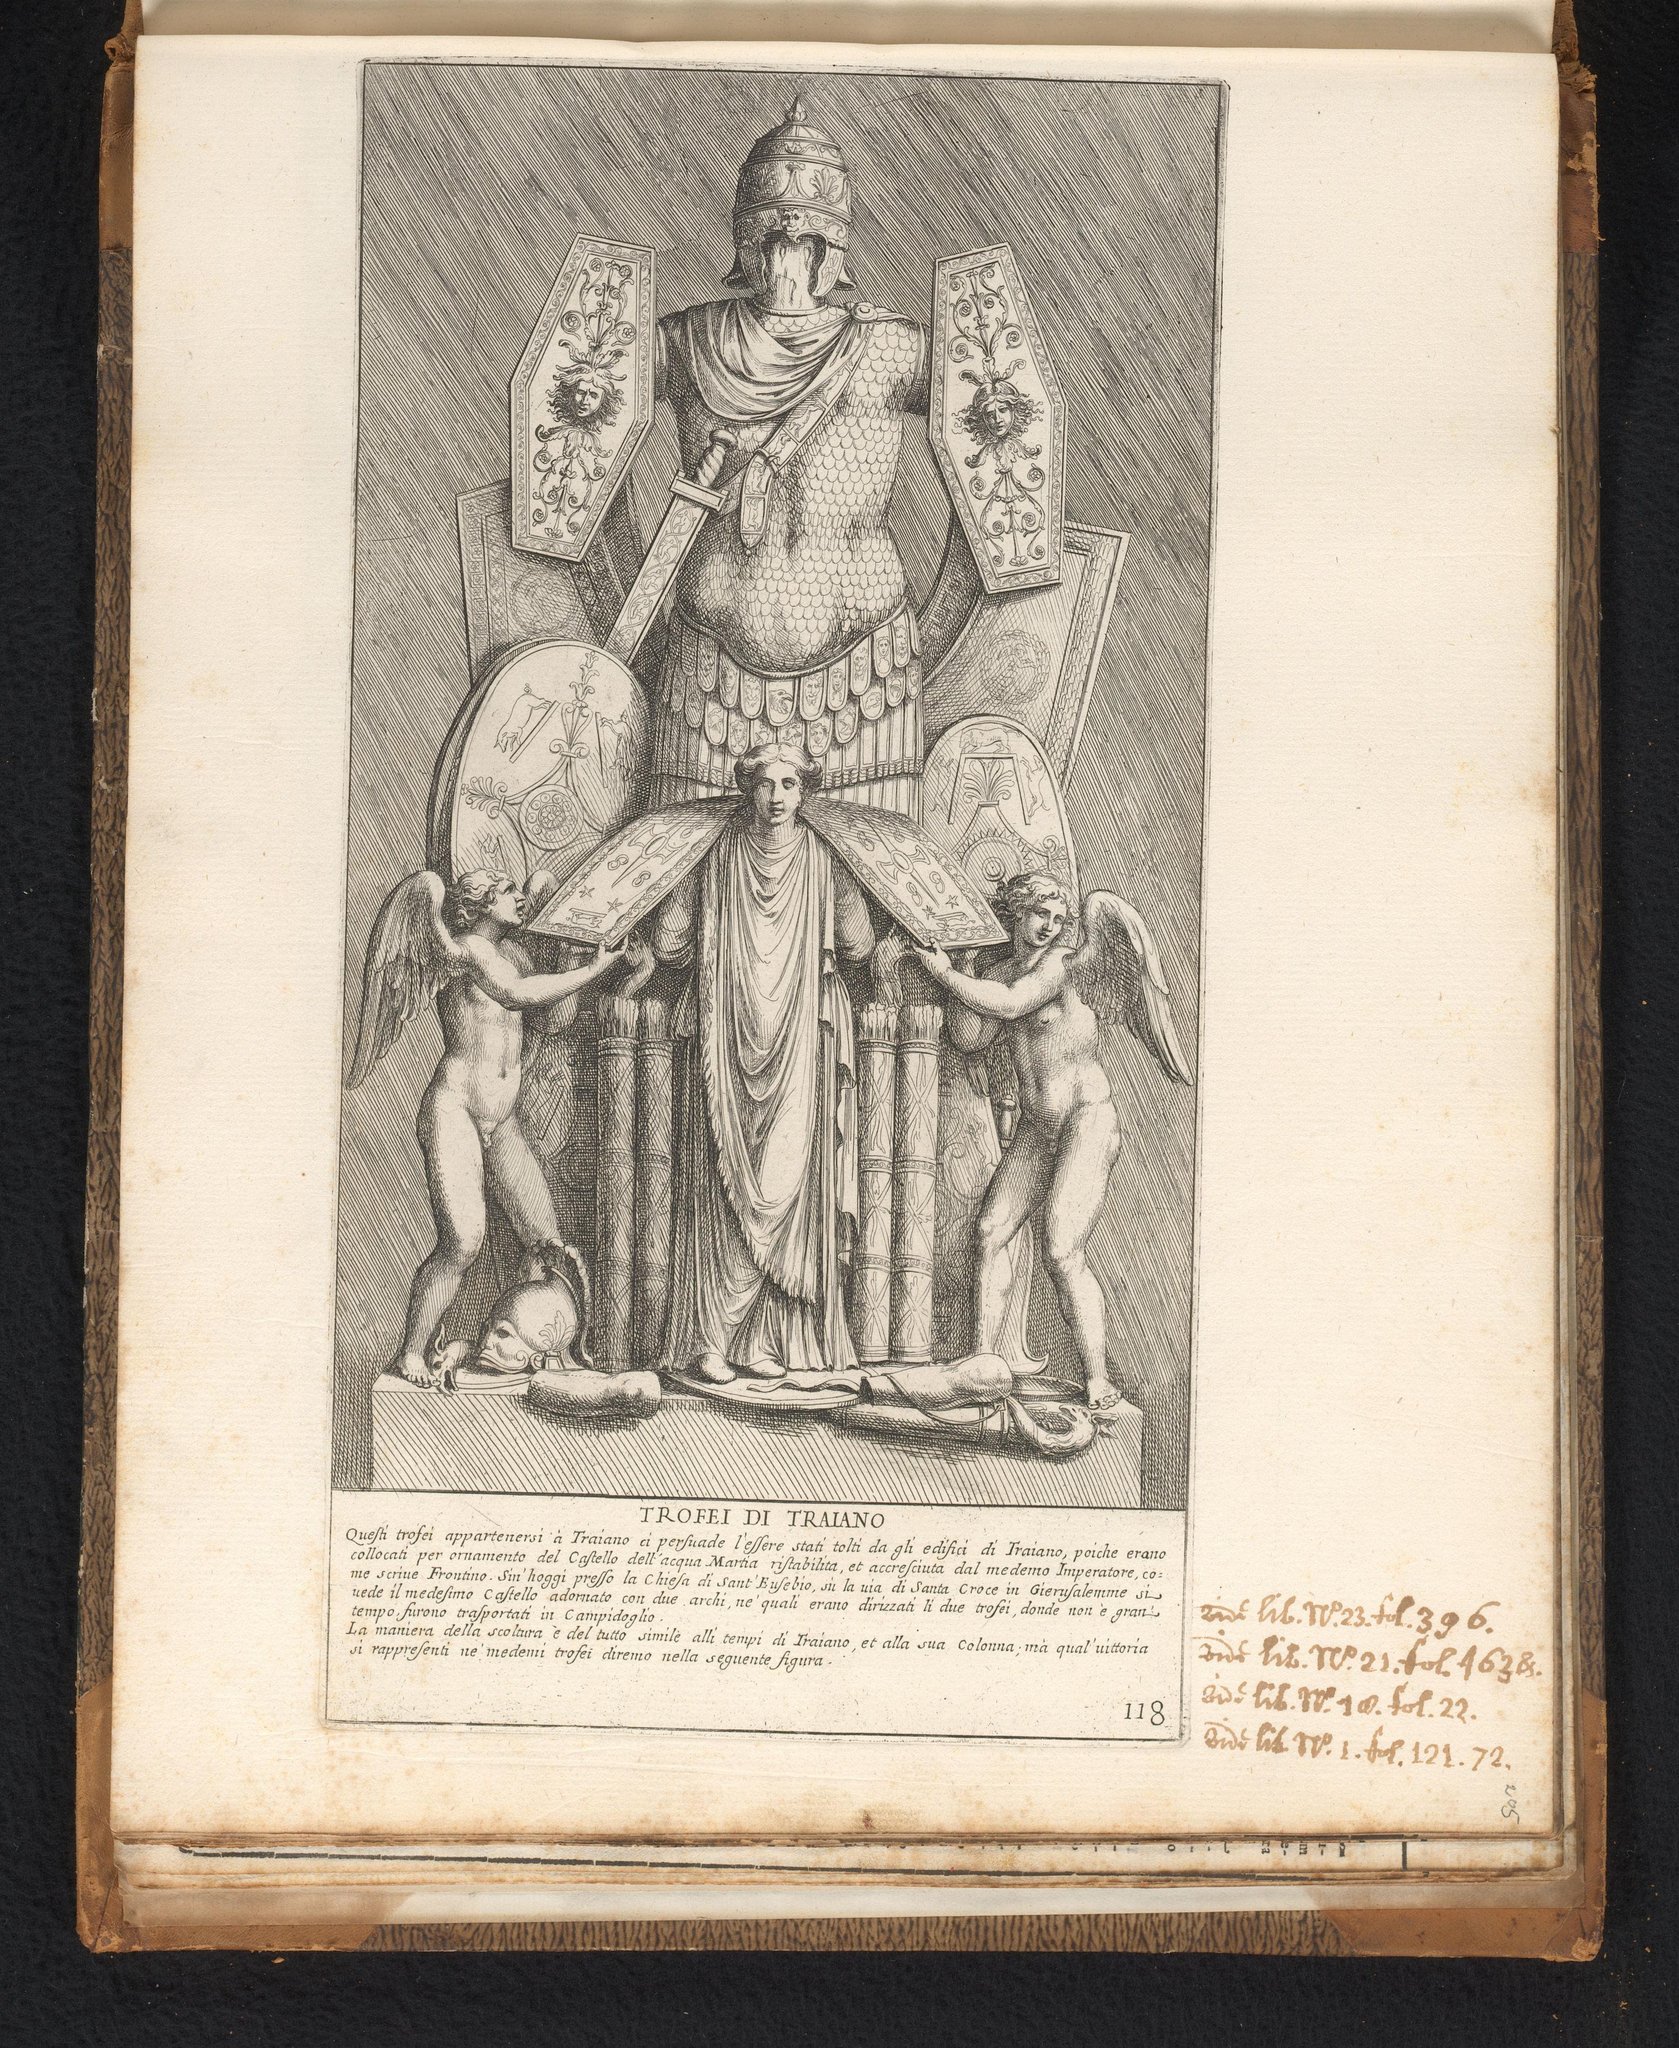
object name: print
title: Trofei di Traiano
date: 1637-1691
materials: paper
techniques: etching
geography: vatican city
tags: trophy ~ battle, war, angels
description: Deze prent maakt deel uit van een reeks van 128 prenten(+ titelprent) (alleen de 119 prenten met details van het grote fries zijn genummerd) met voorstellingen van de Zuil van Trajanus.